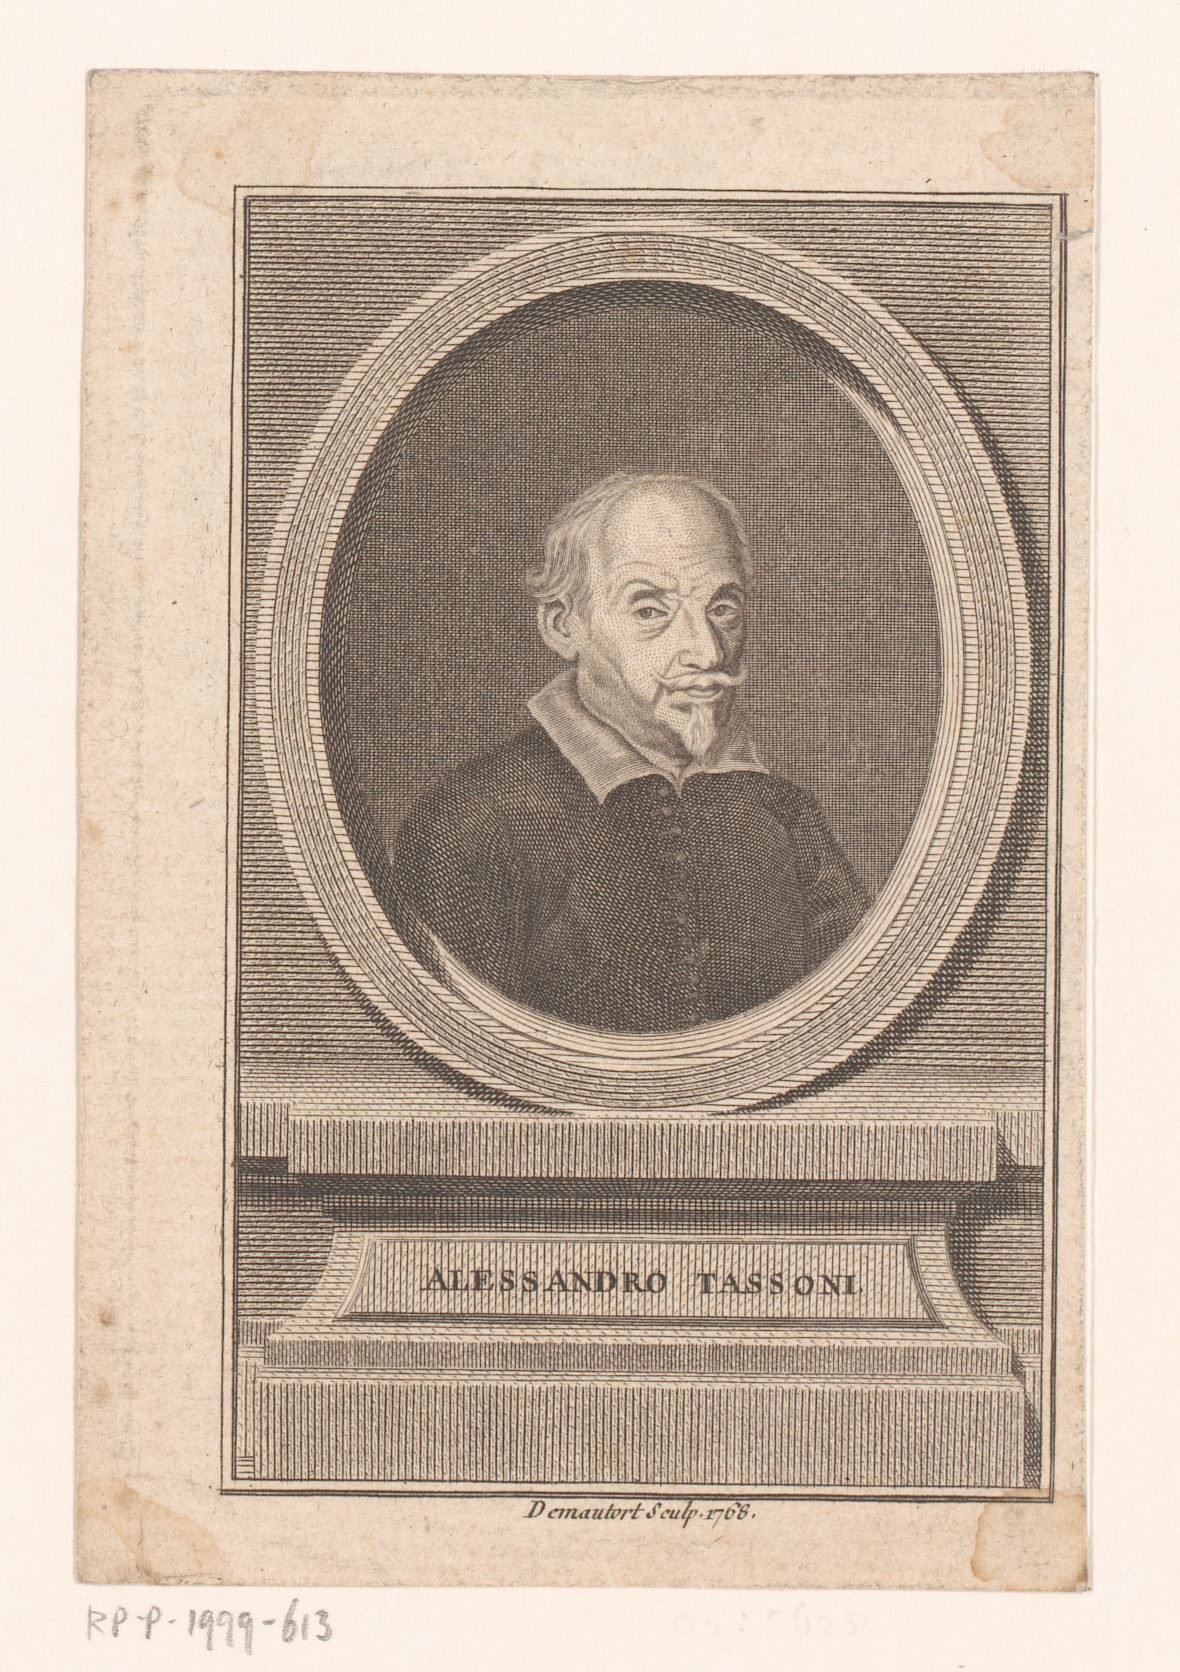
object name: print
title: Portret van Alessandro Tassoni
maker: demautort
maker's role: print maker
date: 1768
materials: paper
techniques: engraving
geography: france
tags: historical persons, portrait of a writer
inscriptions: collector's mark: Lugt 2228